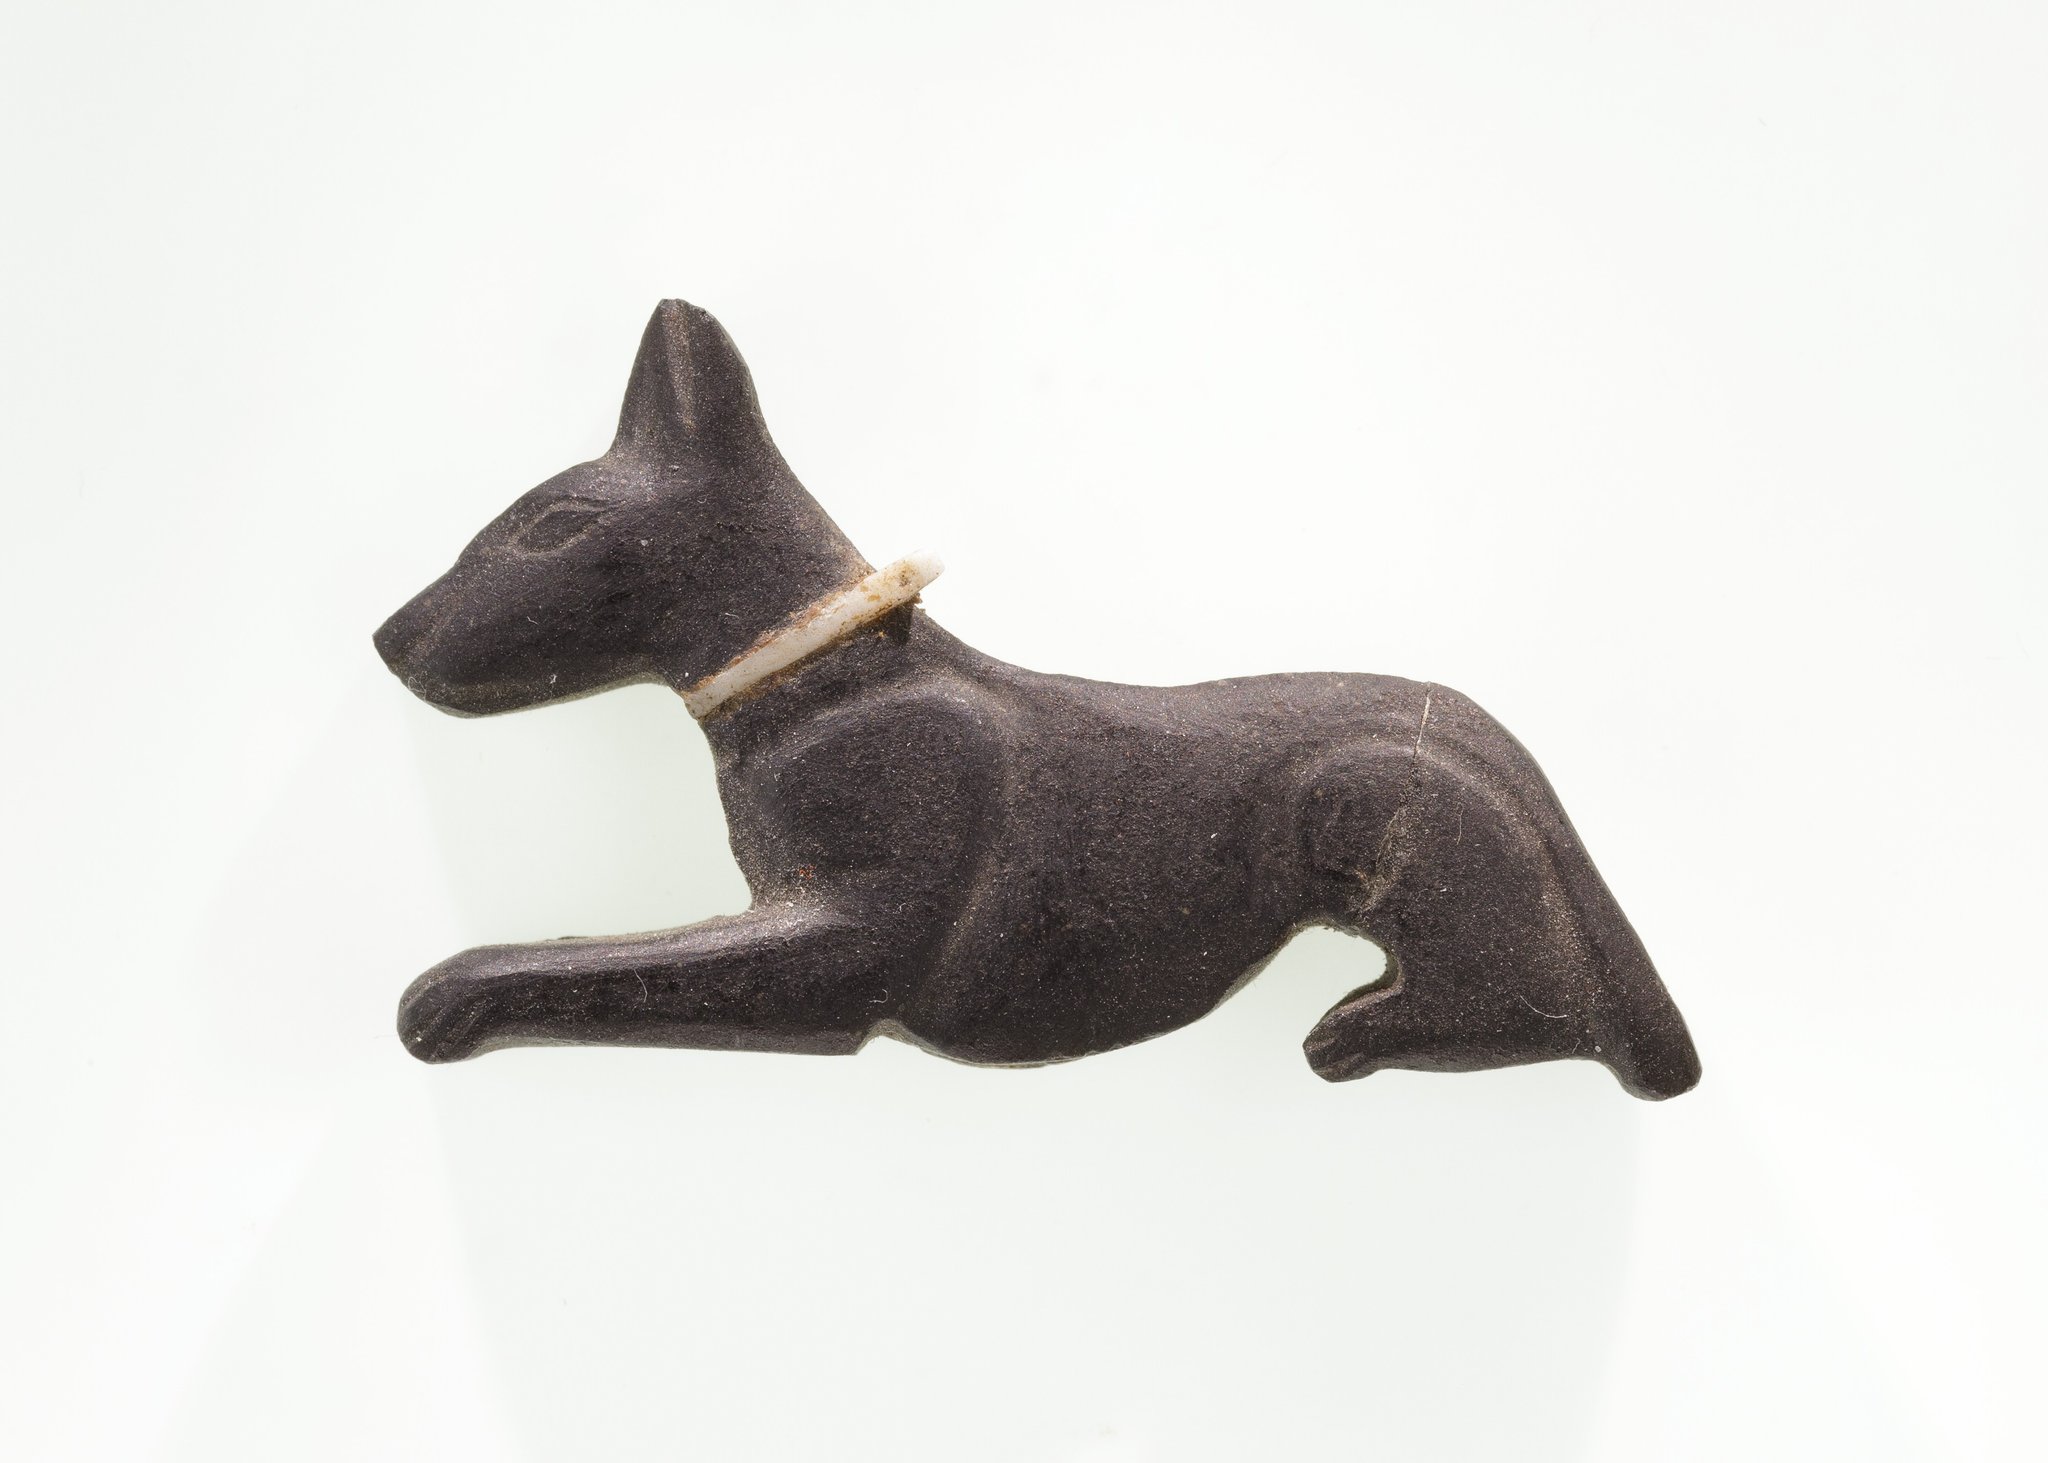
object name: inlay, jackal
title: Jackal Inlay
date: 664-630 BCE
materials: glass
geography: egypt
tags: jackals